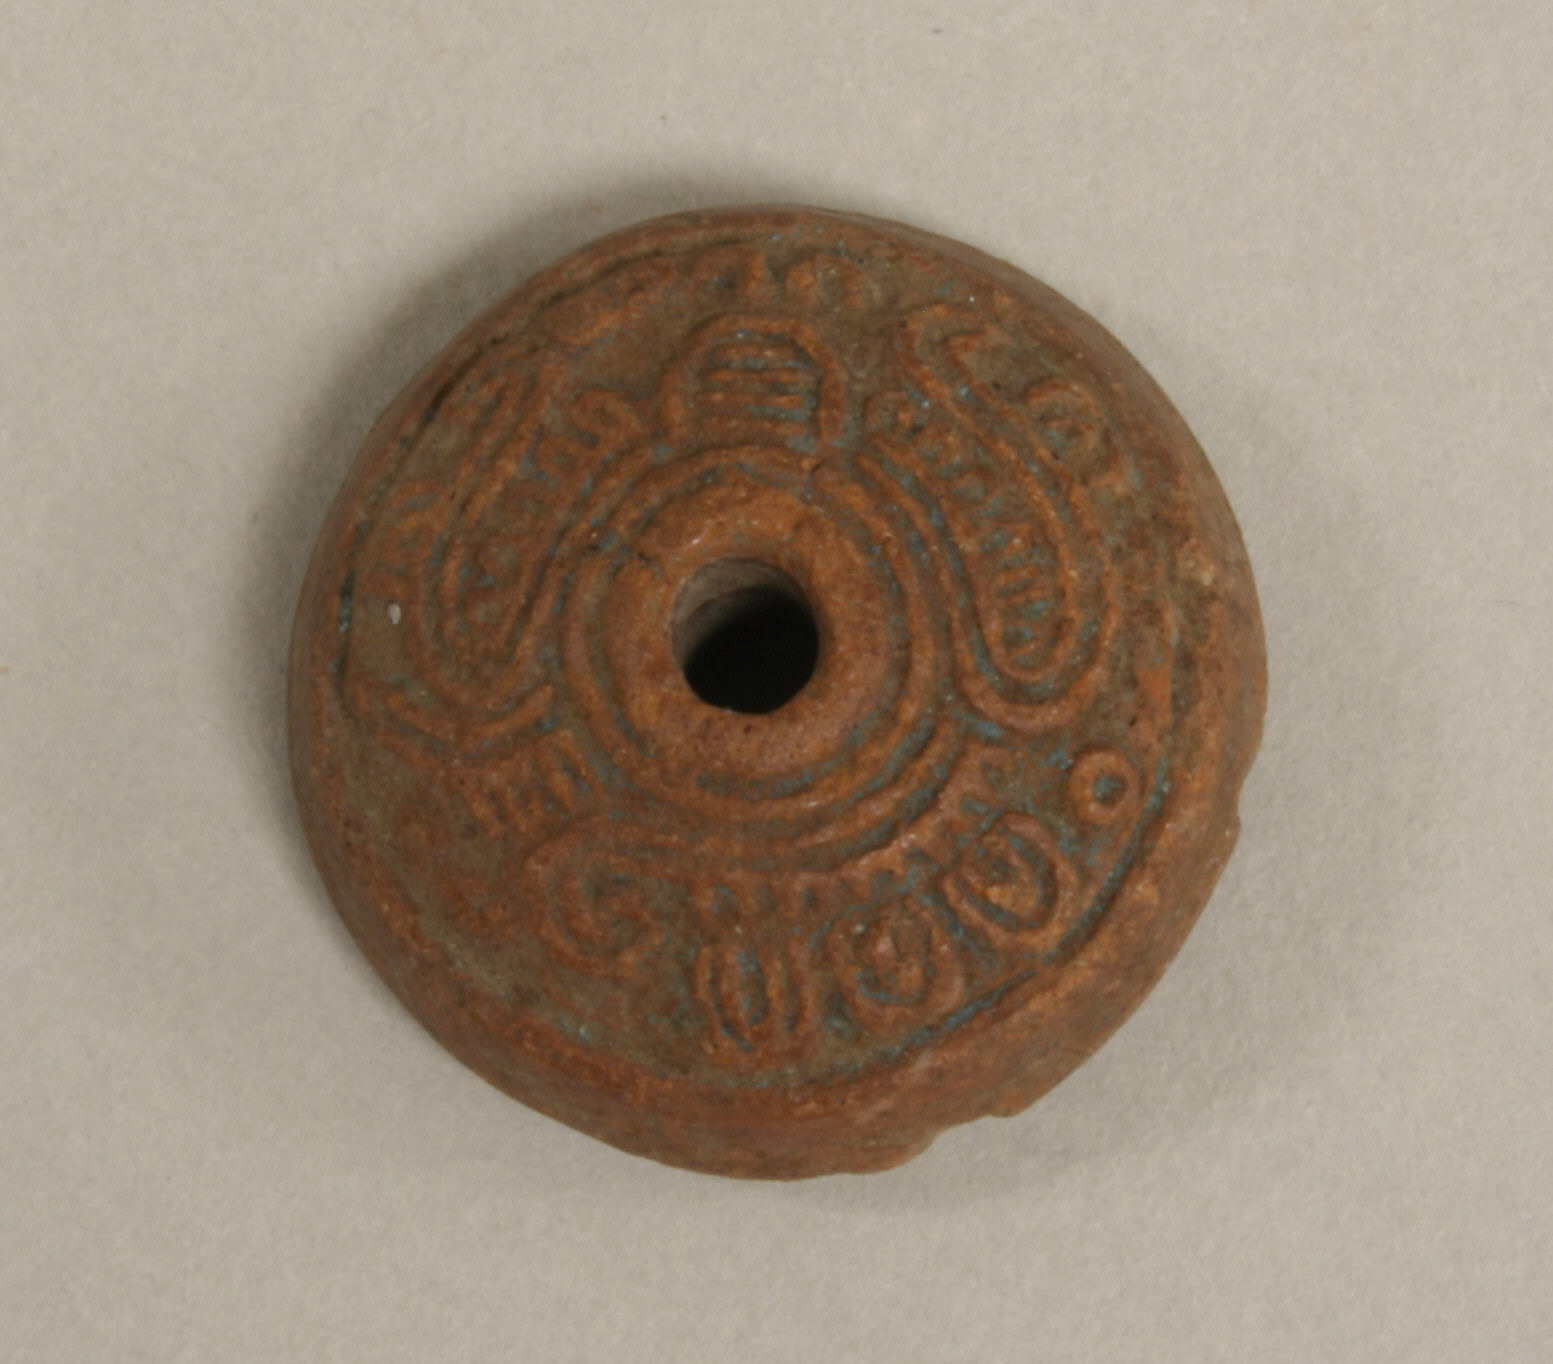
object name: spindle whorl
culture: mexican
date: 801-1500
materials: ceramic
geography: mexico